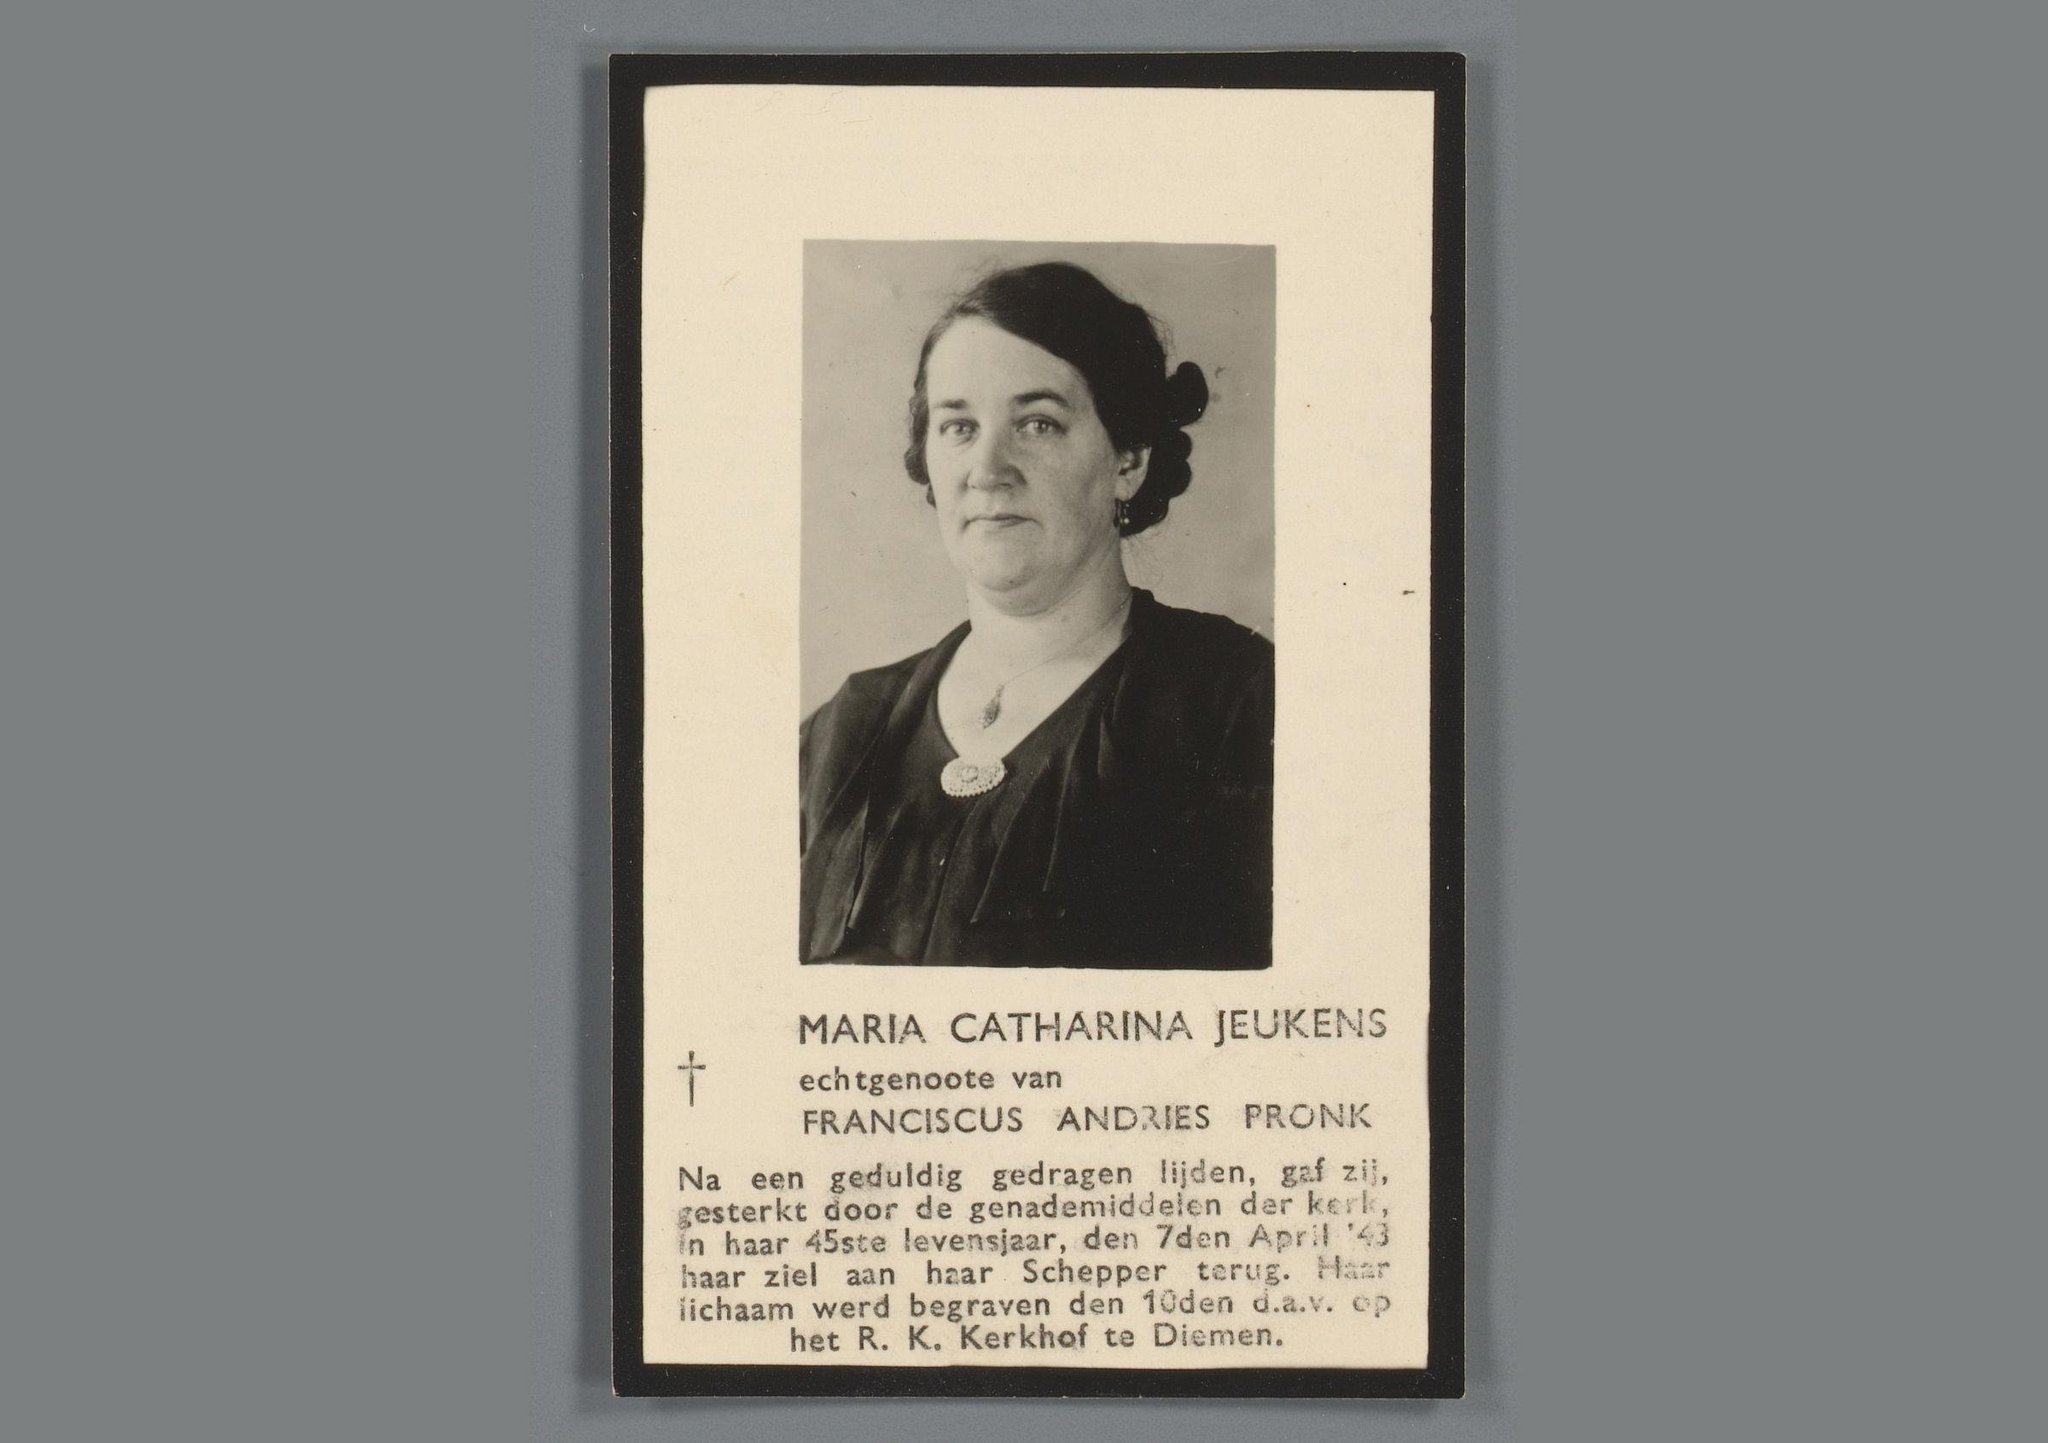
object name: prayer card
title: Portret van Maria Catharina Jeukens op bidprent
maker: Anonymous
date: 1943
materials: paper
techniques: gelatin silver print, letterpress printing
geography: diemen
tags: adult woman, historical persons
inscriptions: inscription: ‘Voor een dierbare overledene (...) verhoord te zullen worden. Amen.’, factory mark: ‘Agfa-Lupex’, inscription: ‘Maria Catharina Jeukens (...) het R.K. Kerkhof te Diemen.’